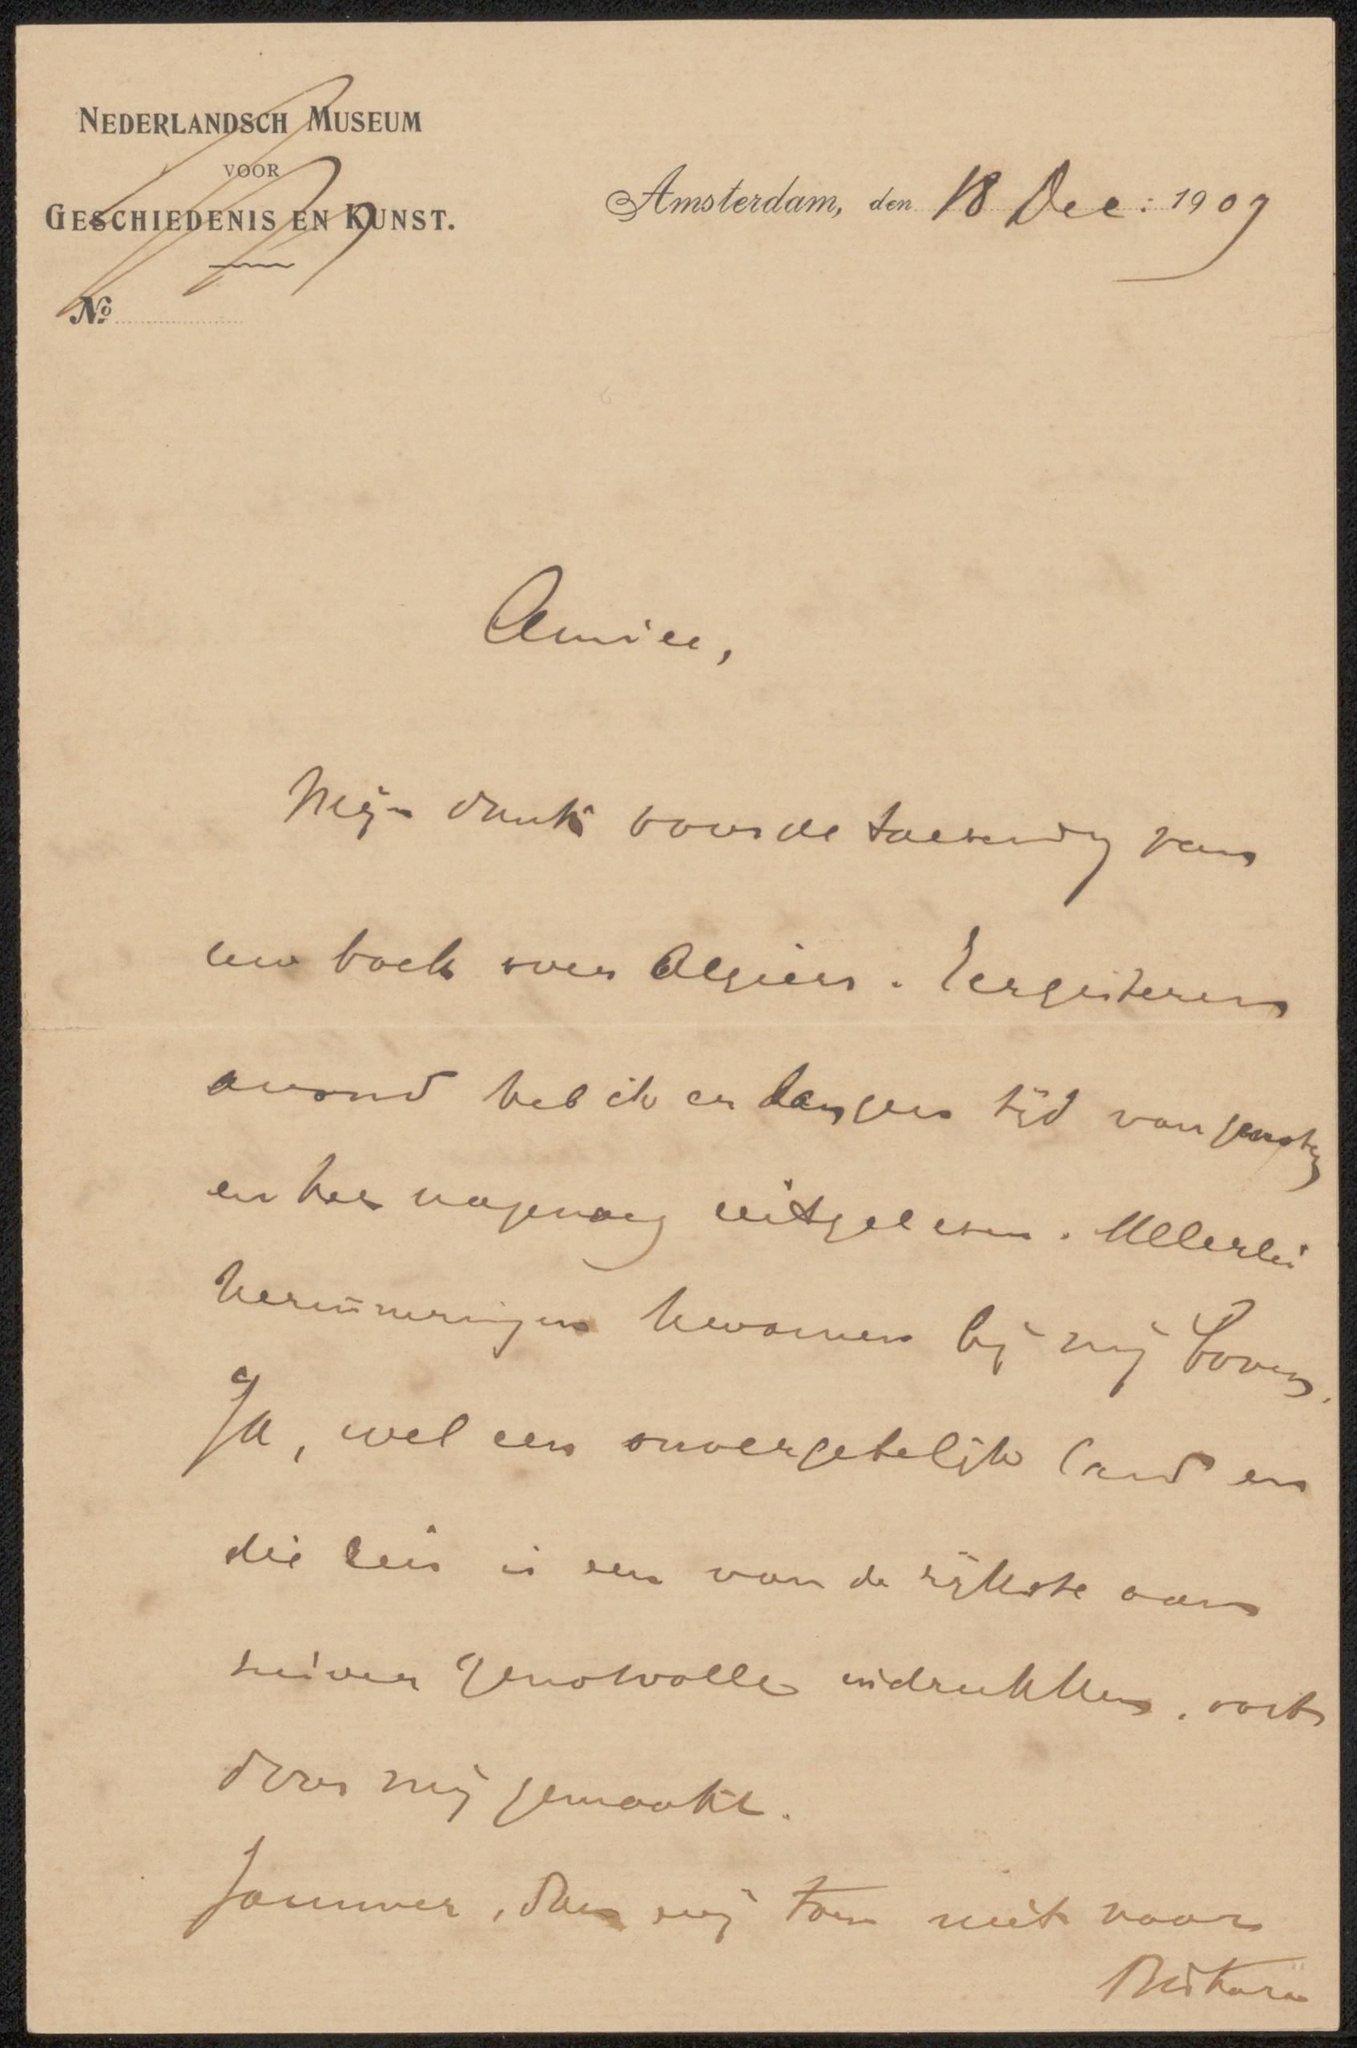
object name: letter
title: Brief aan Philip Zilcken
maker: adriaan pit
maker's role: print maker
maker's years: 1860-1944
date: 1909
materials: ink, paper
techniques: pen, printing, writing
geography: amsterdam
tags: painter, philip zilcken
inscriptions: collector's mark: ‘RPK’